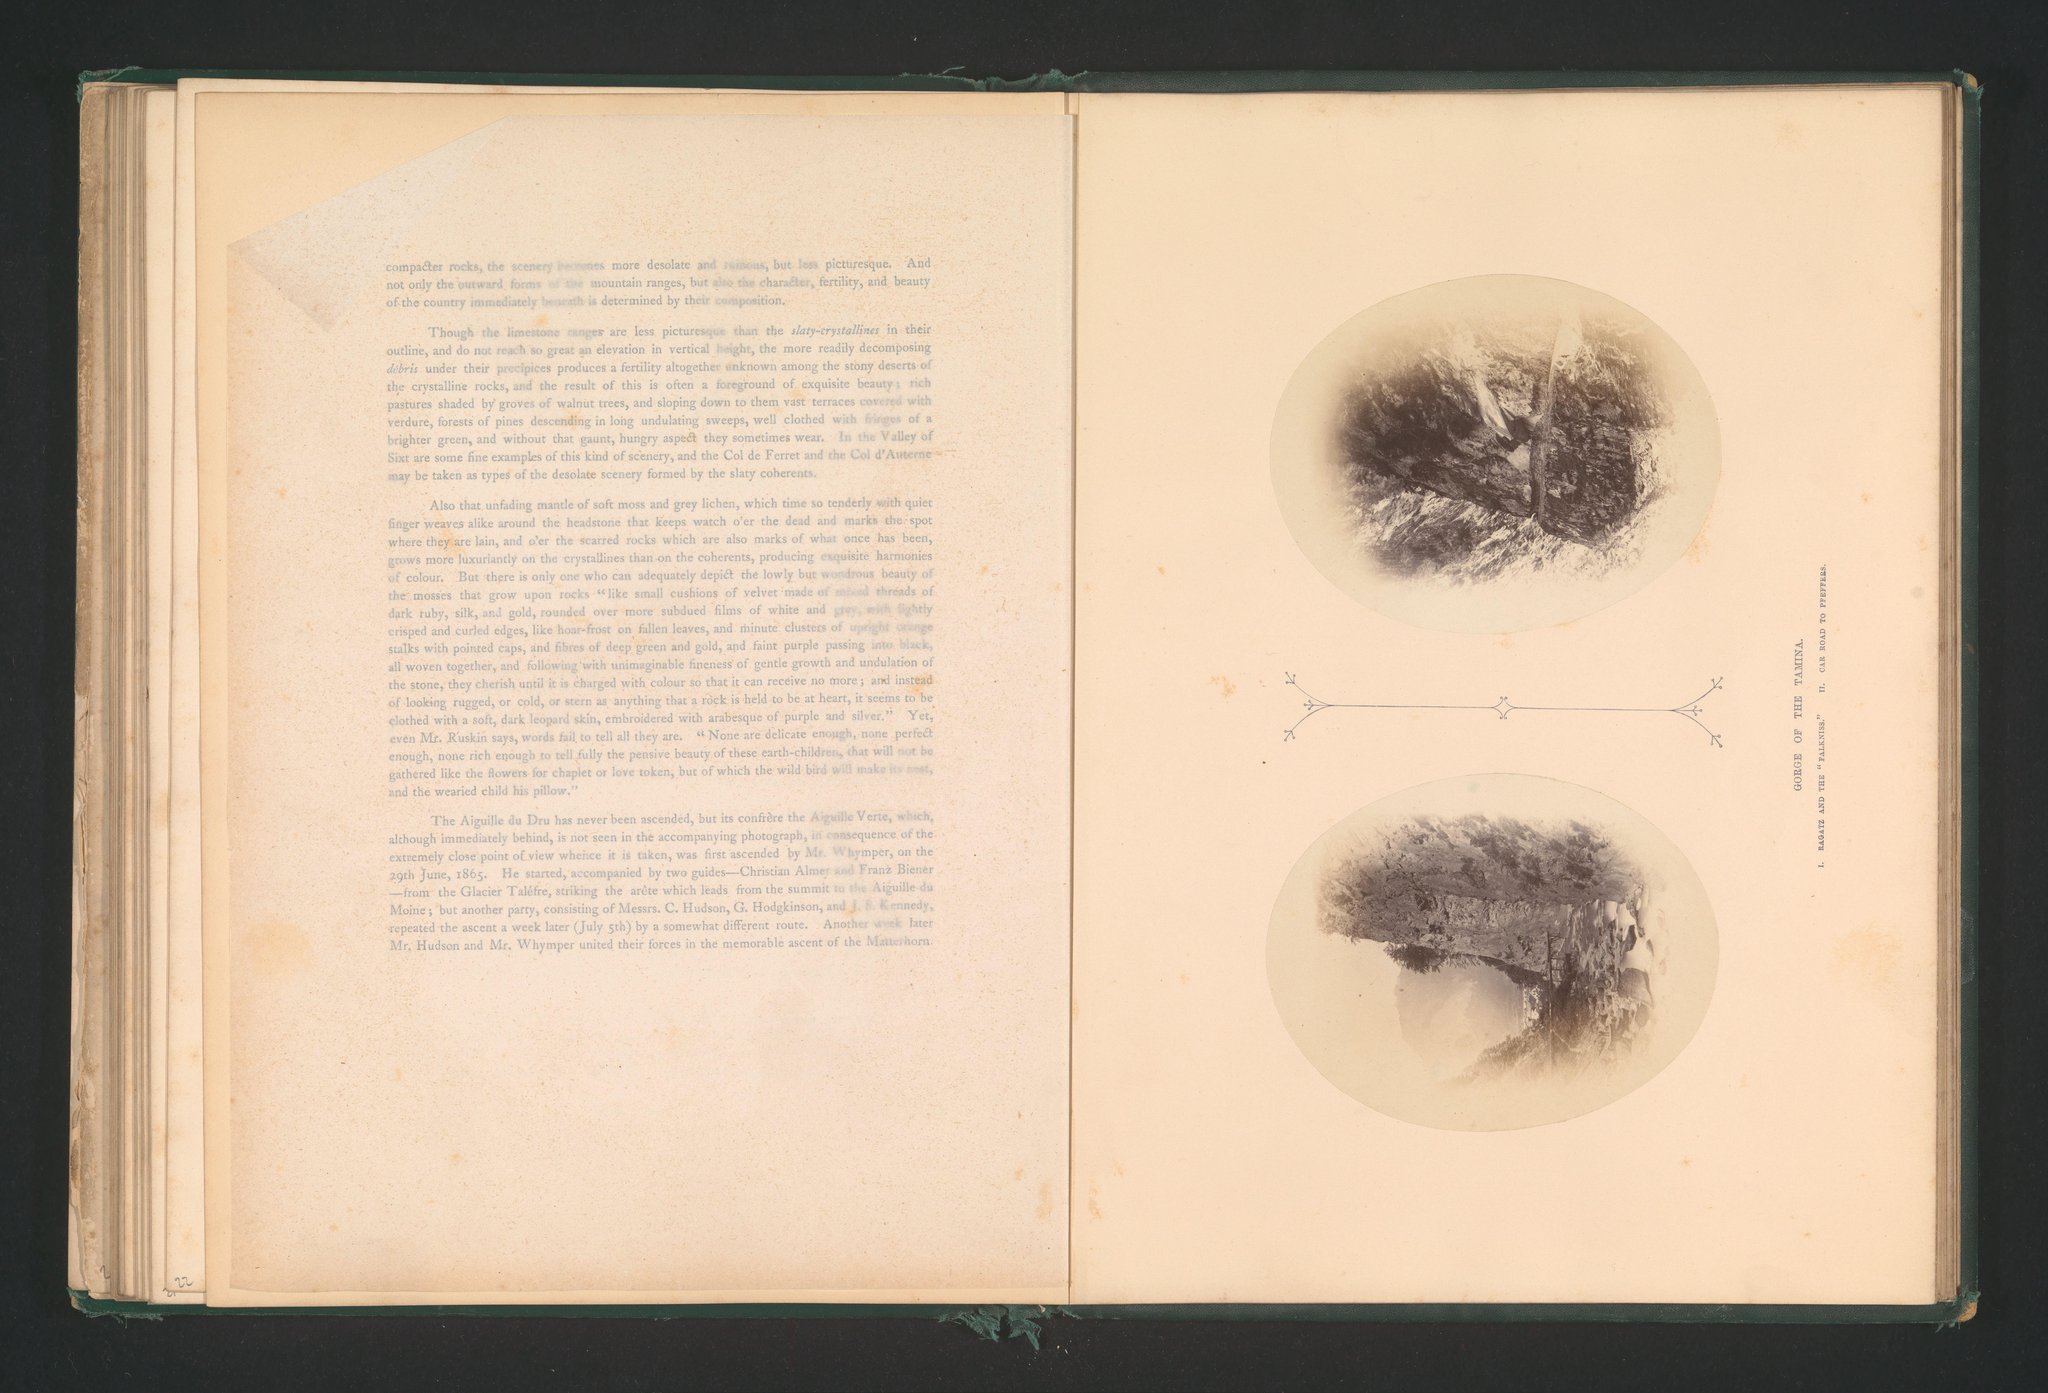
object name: page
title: Gezicht op een weg door de kloof van Tamina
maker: stephen thompson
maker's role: fotograaf, schrijver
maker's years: 1831-1893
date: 1863-1868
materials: photographic support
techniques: albumen print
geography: tamina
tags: river, public road, ravine, chasm, abyss, canyon (+ landscape with figures, staffage)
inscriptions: inscription: ‘II. Car road to Pfeffers’